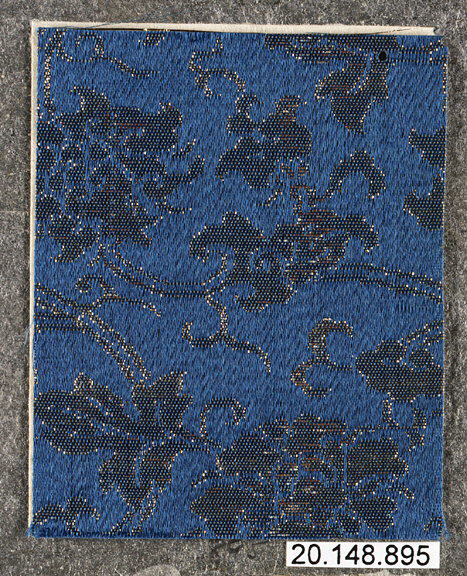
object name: textile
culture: china or japan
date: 1701-1800